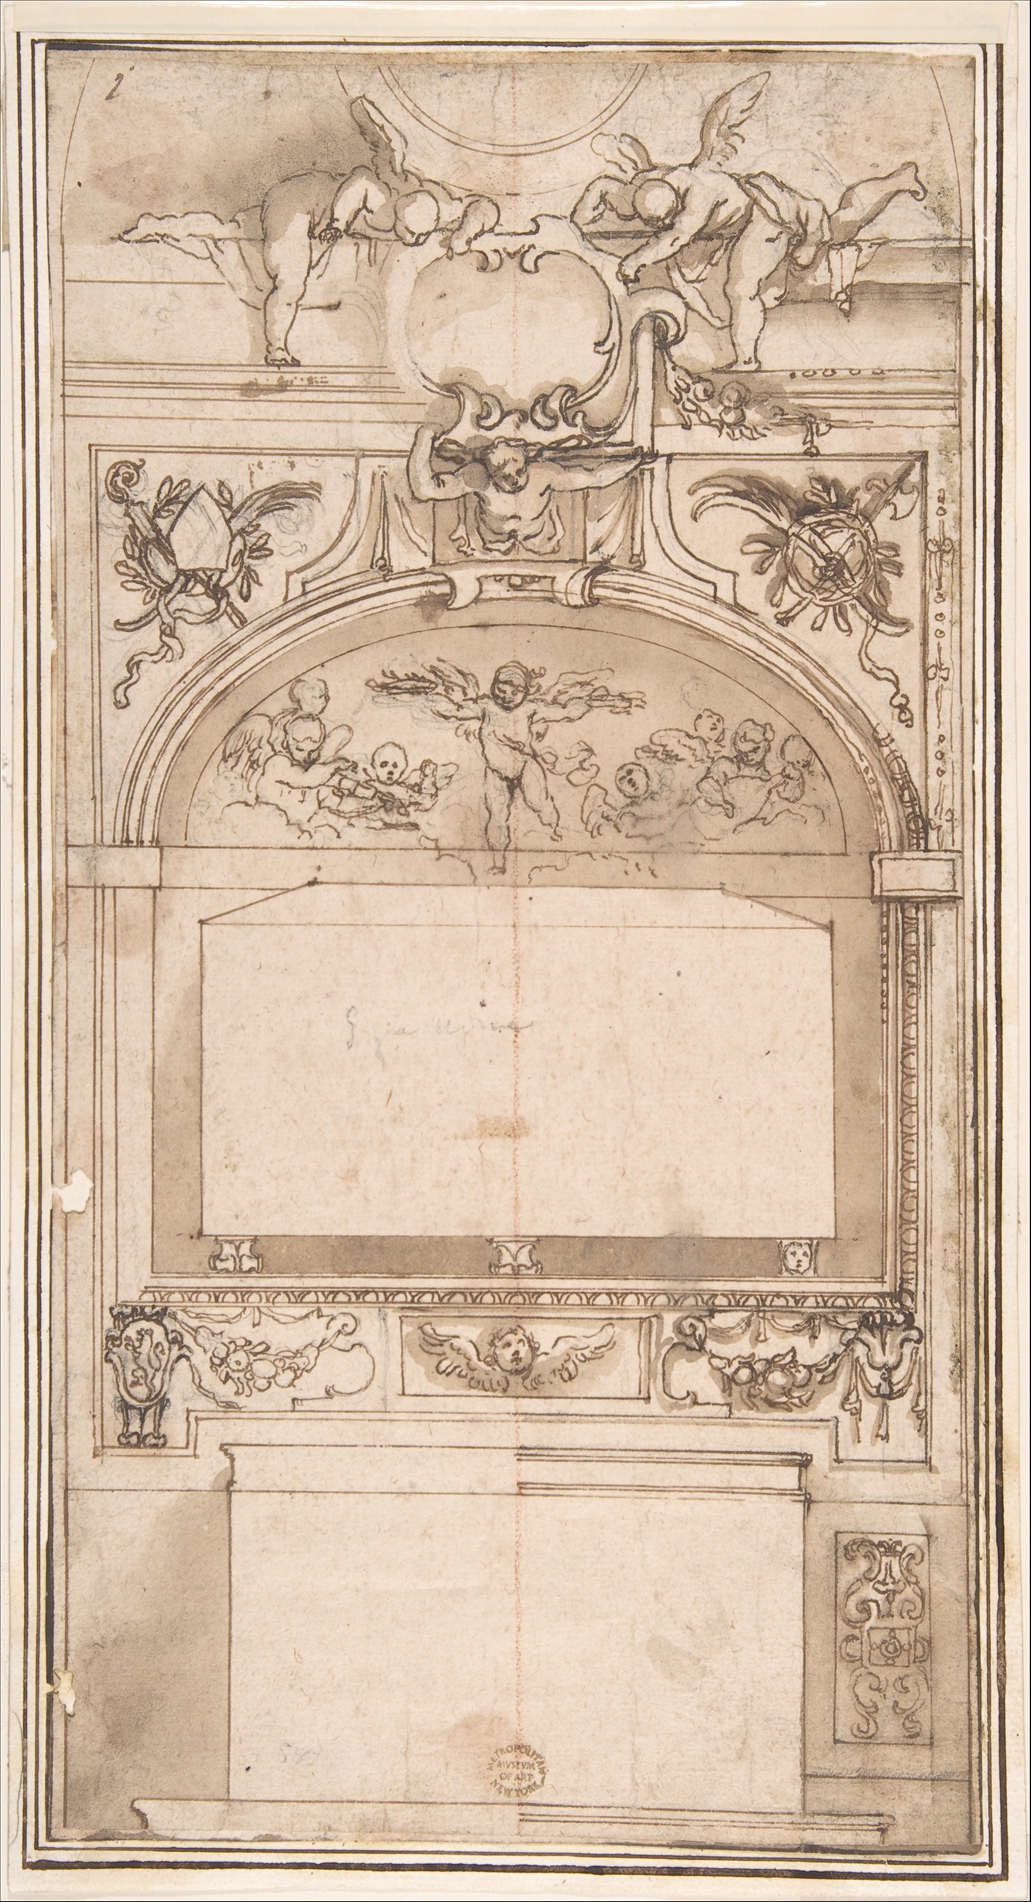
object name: drawing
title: Wall Monument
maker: anonymous, italian, 16th century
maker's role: artist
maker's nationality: italian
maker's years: 1550-1600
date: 1501-1600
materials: ink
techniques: pen, wash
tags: architecture,monuments